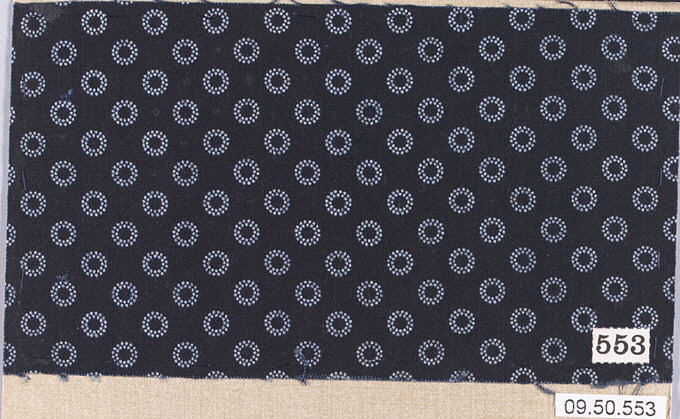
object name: piece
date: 1801-1900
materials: cotton